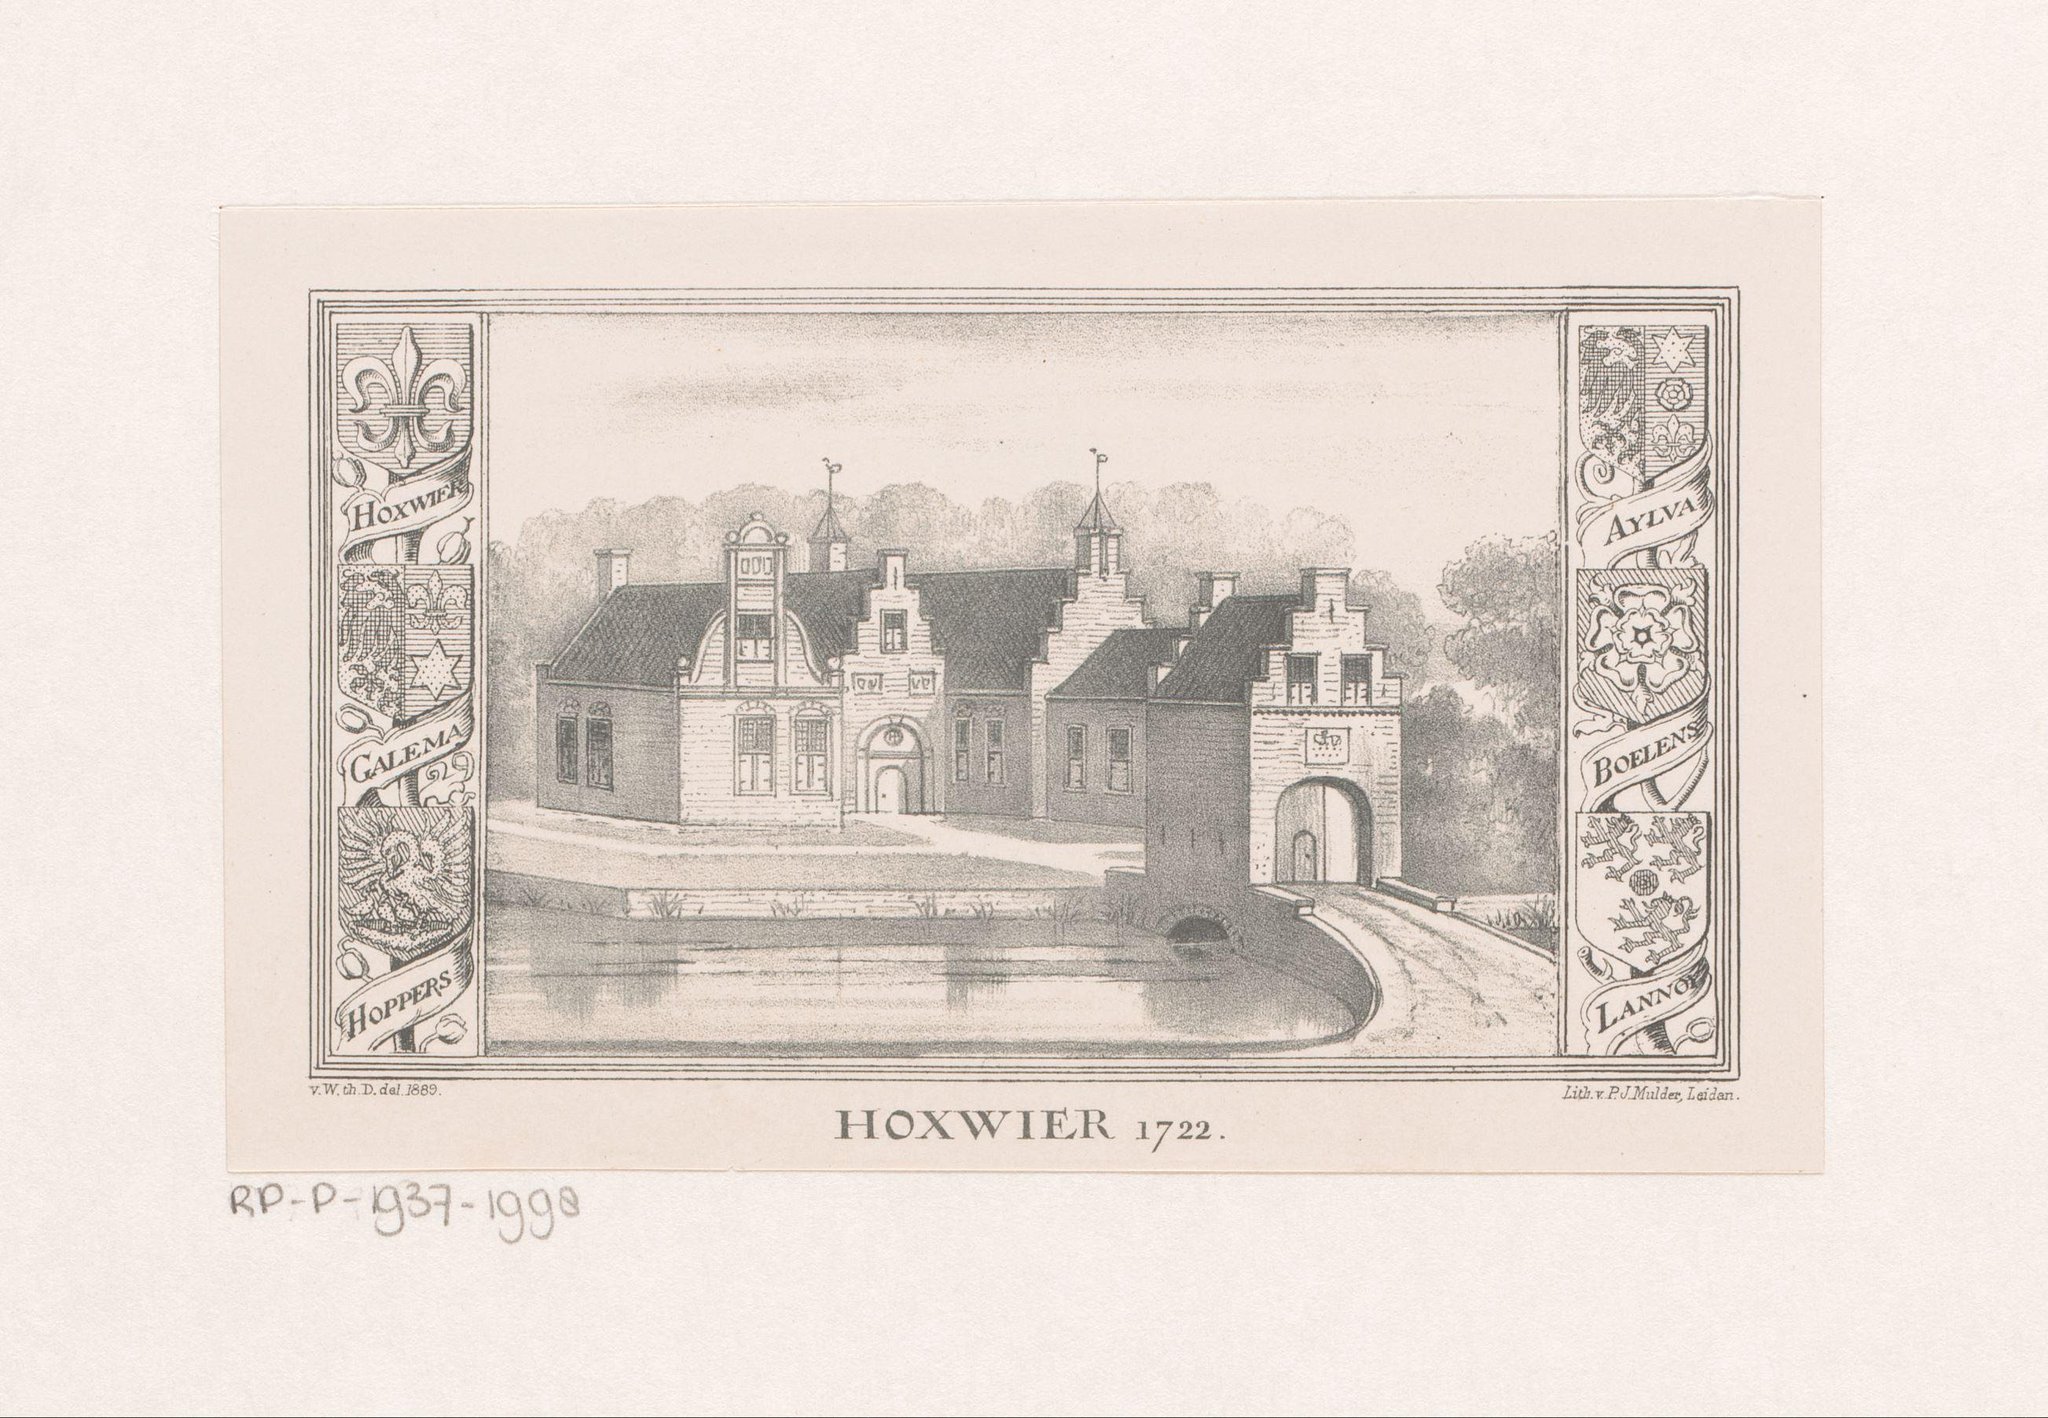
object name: book illustration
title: Gezicht op Kasteel Hoxwier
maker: jan hendrik jetse wageningen thoe dekema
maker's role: schrijver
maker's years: 1860-1908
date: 1889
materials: paper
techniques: lithograph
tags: castle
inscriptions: collector's mark: Lugt 2760, collector's mark: Lugt 2228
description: Gezicht op het kasteel te Hoxwier (gelegen tussen Leeuwaren en Mantgum), gelegen aan het water. Links en rechts drie wapenschilden.